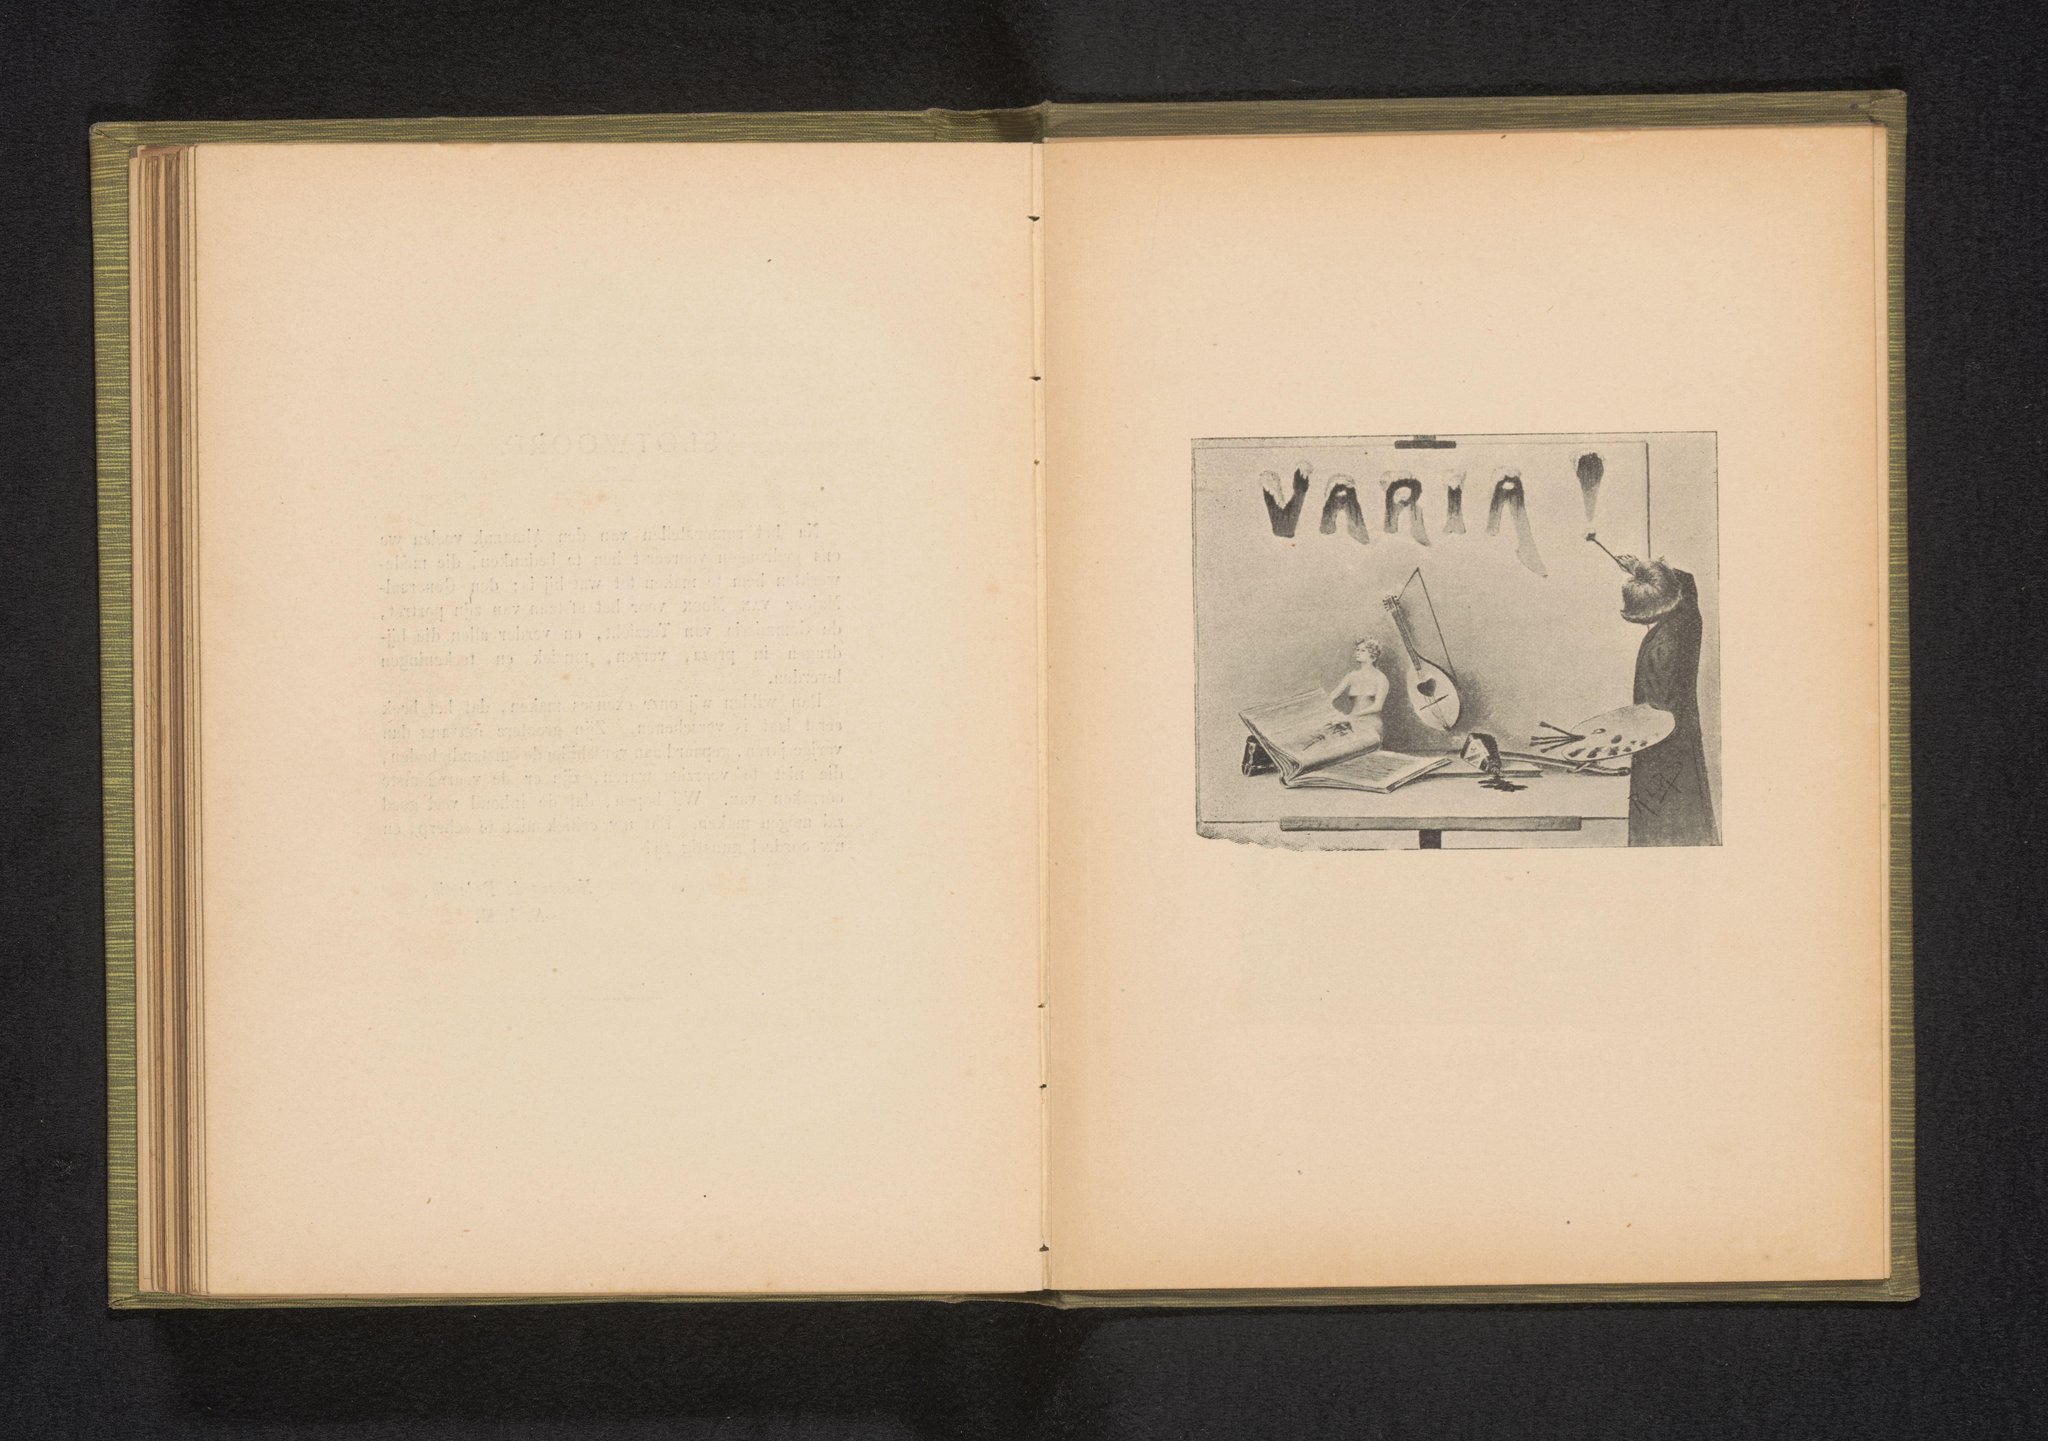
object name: photomechanical print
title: Reproductie van een prent met varia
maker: Anonymous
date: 1901-1906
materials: paper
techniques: autotype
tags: book - mm - book open, palette, cithern, mandolin, guitar, balalaika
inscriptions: monogram: ‘R. LAS’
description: Prent op derde ongenummerde pagina na pagina 140.